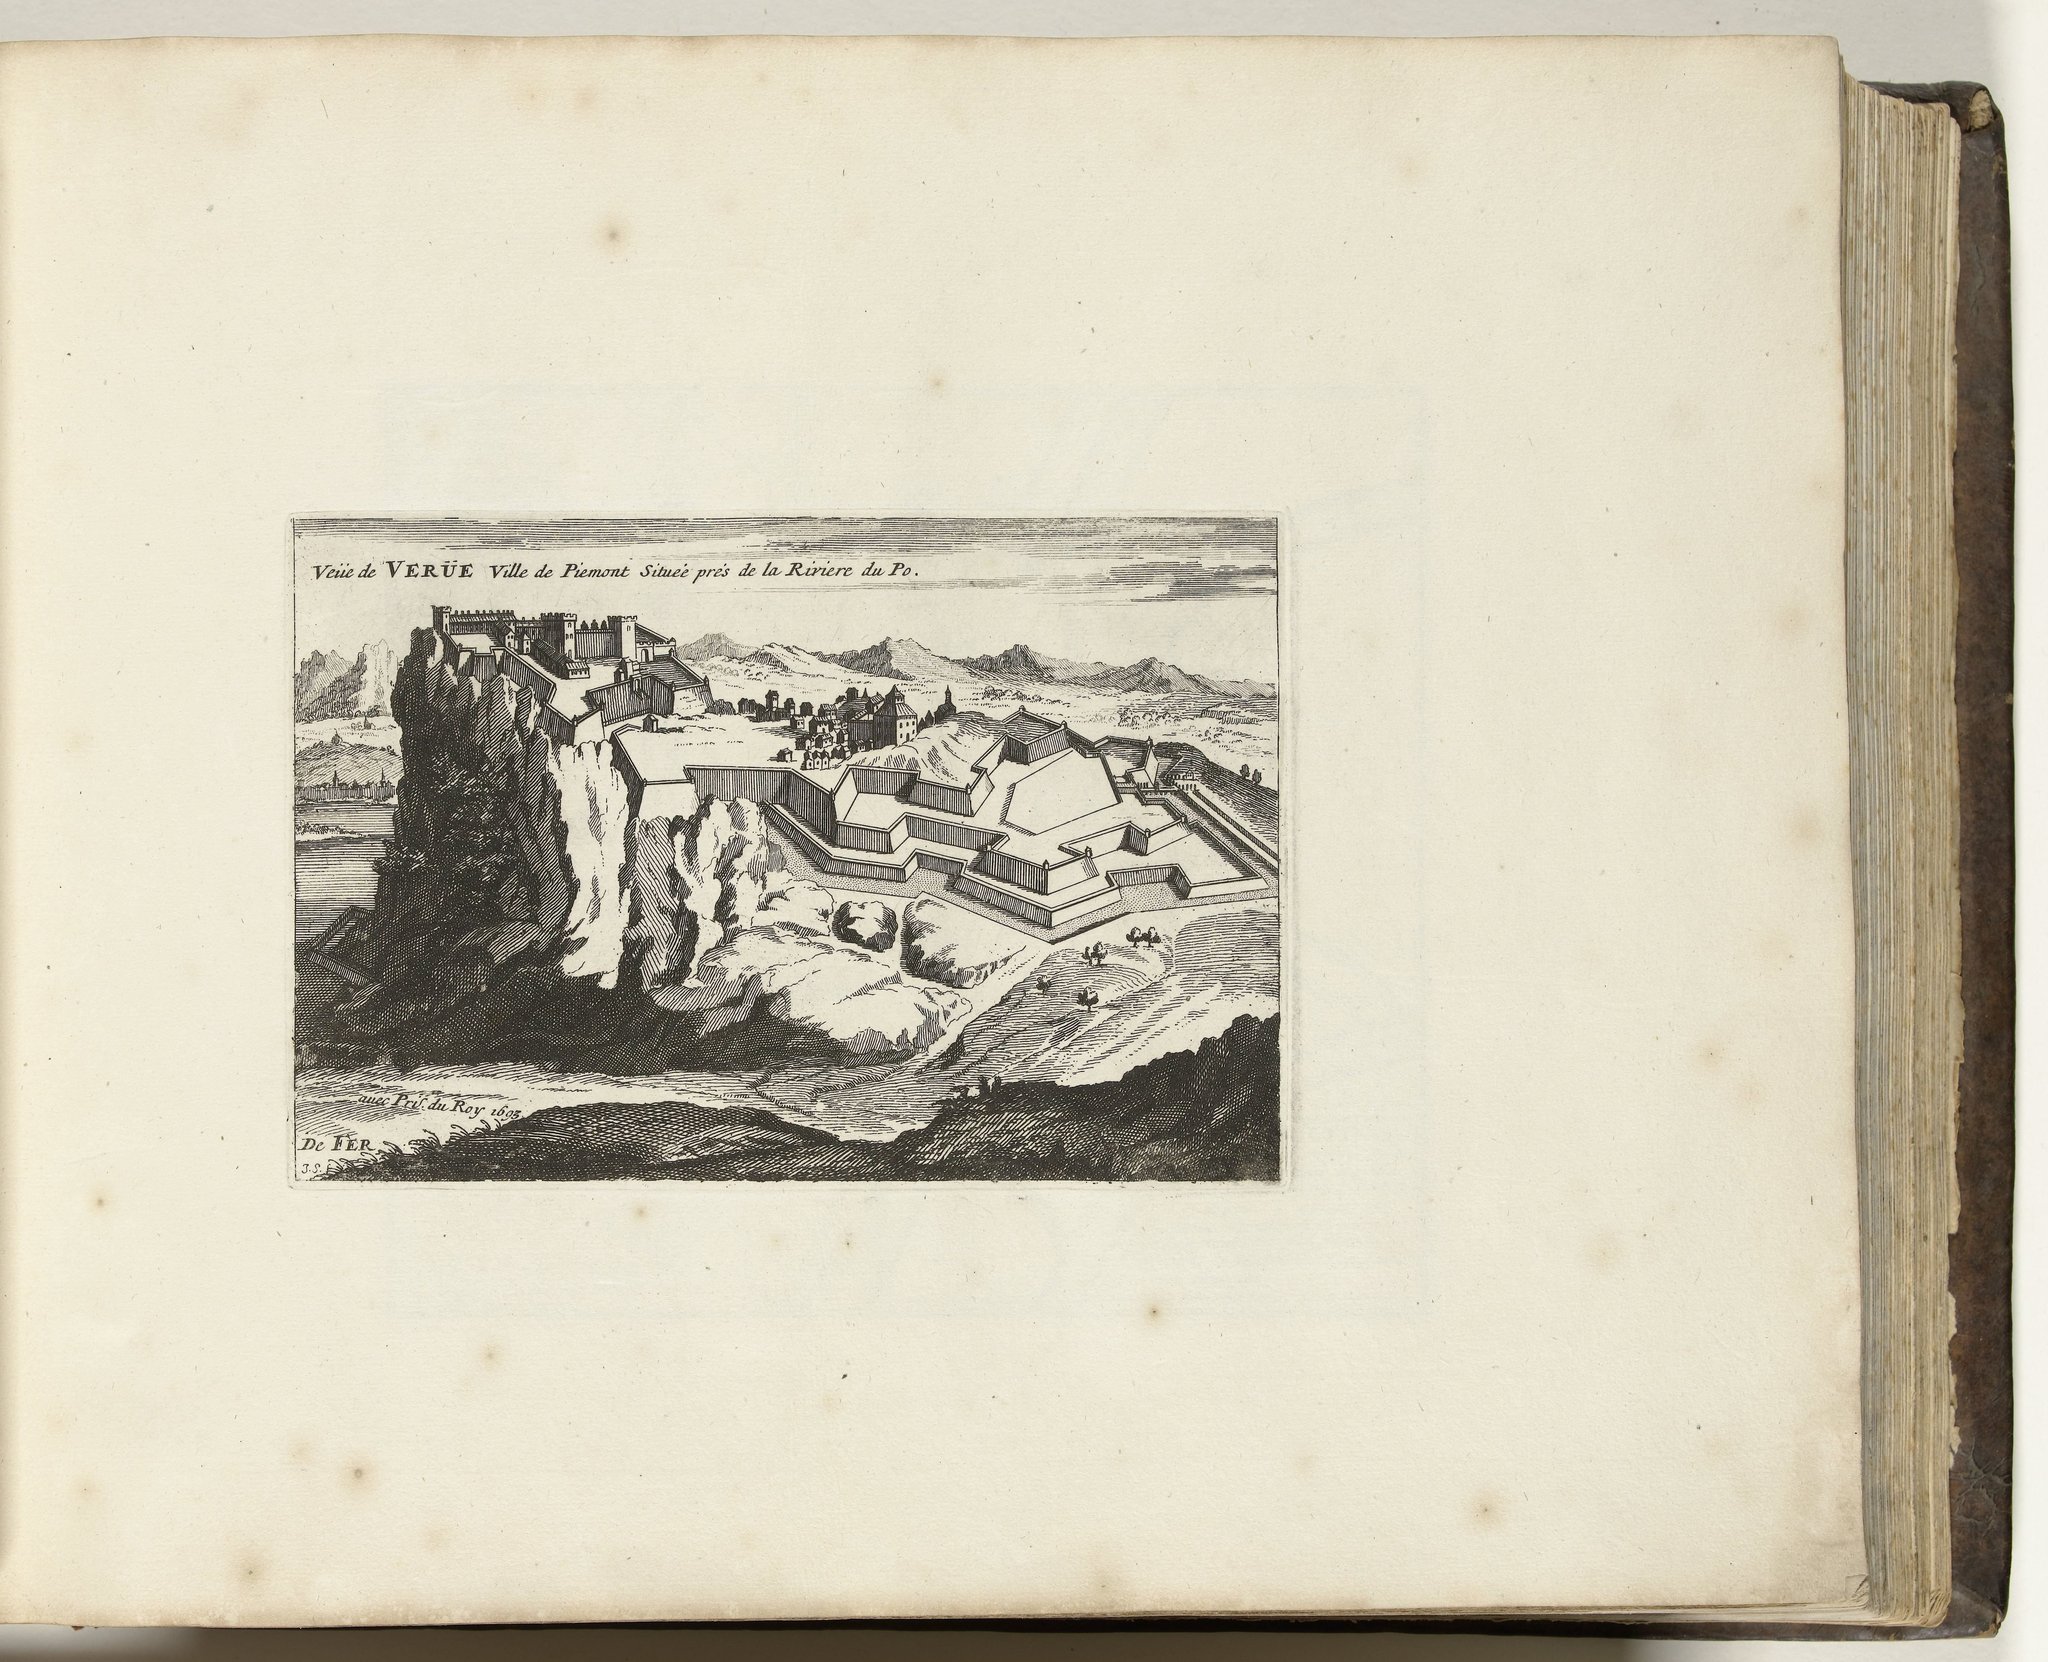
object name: print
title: Les forces de l'Europe, ou description des principales villes, avec leurs fortifications : dessignées par les meilleurs ingenieurs, particulierement celles (...) de la France, dont les plans ont esté levez par M. de Vauban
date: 1693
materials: paper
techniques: etching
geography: paris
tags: fortress, maps of cities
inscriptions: date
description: Gezicht op de Italiaanse stad Verua (Verue) aan de Po in Piemonte. Onderdeel van het tweede deel (1693) van het prentwerk waarin gebundeld zijn de acht delen van Les forces de l'Europe uitgegeven tussen 1693-1697. Het prentwerk bestaat uit 175 platen met plannen (afkomstig van Sébastien Le Prestre, Seigneur de Vauban) van vermaarde sterke steden en vestingen in de Negenjarige Oorlog. Titel en opschriften in het Frans.